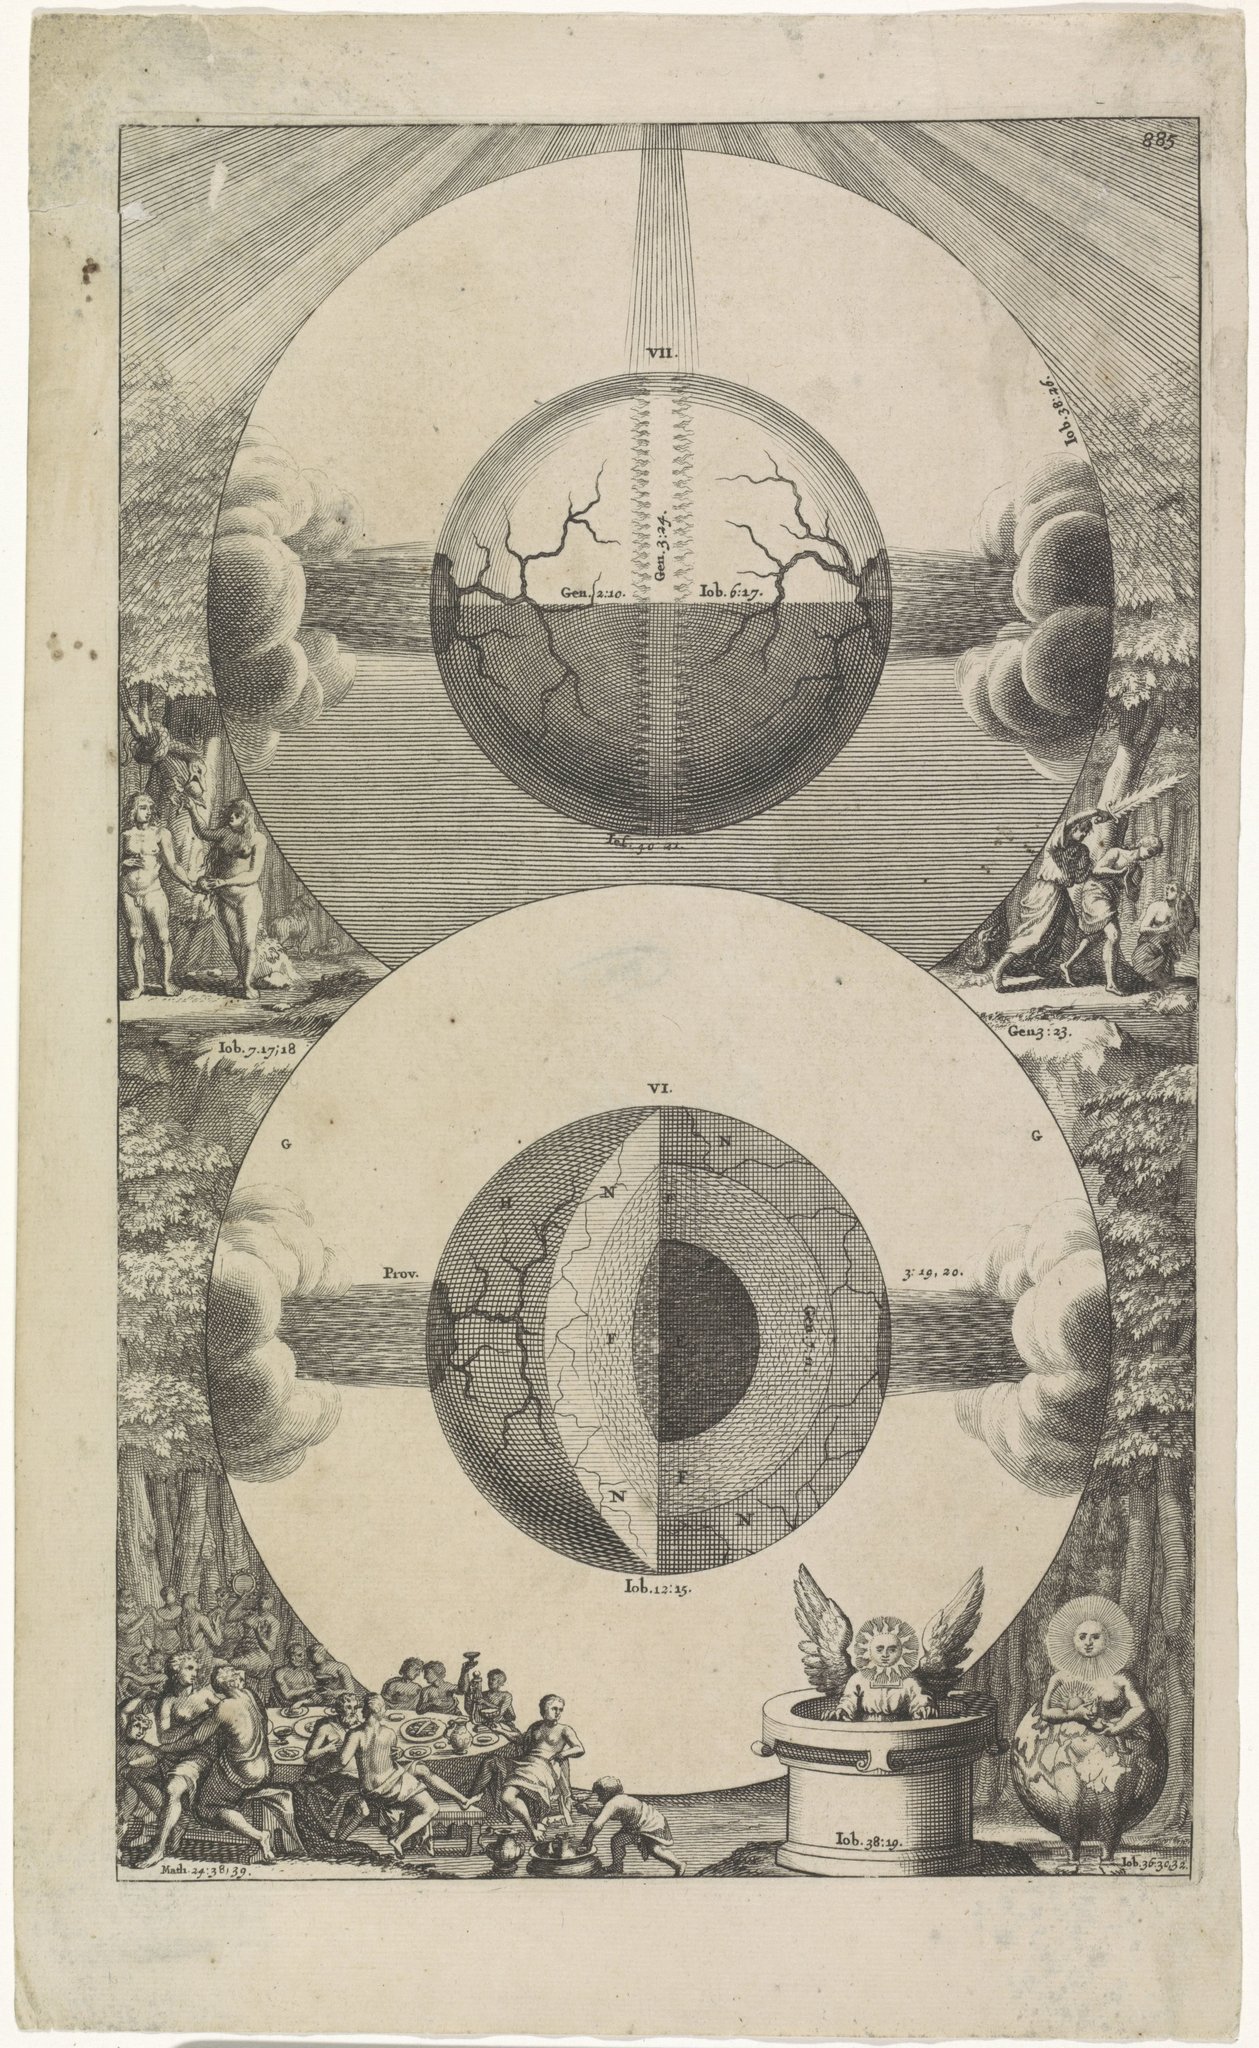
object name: print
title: Twee globes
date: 1690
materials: paper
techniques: engraving, etching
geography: amsterdam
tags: earth, world as celestial body, an angel chases adam and eve out of paradise with a (flaming) sword, temptation and fall (scenes with both adam and eve)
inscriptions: collector's mark: Lugt 2228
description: Boven de aarde met watervertakkingen. Aan weerszijden de zondeval en de verdrijving uit het paradijs. Onder de aarde waarbij de verschillende lagen zichtbaar zijn gemaakt. Linksonder een feestmaal. Bij de voorstellingen verschillende Bijbel verwijzingen. Rechtsboven genummerd: 885.